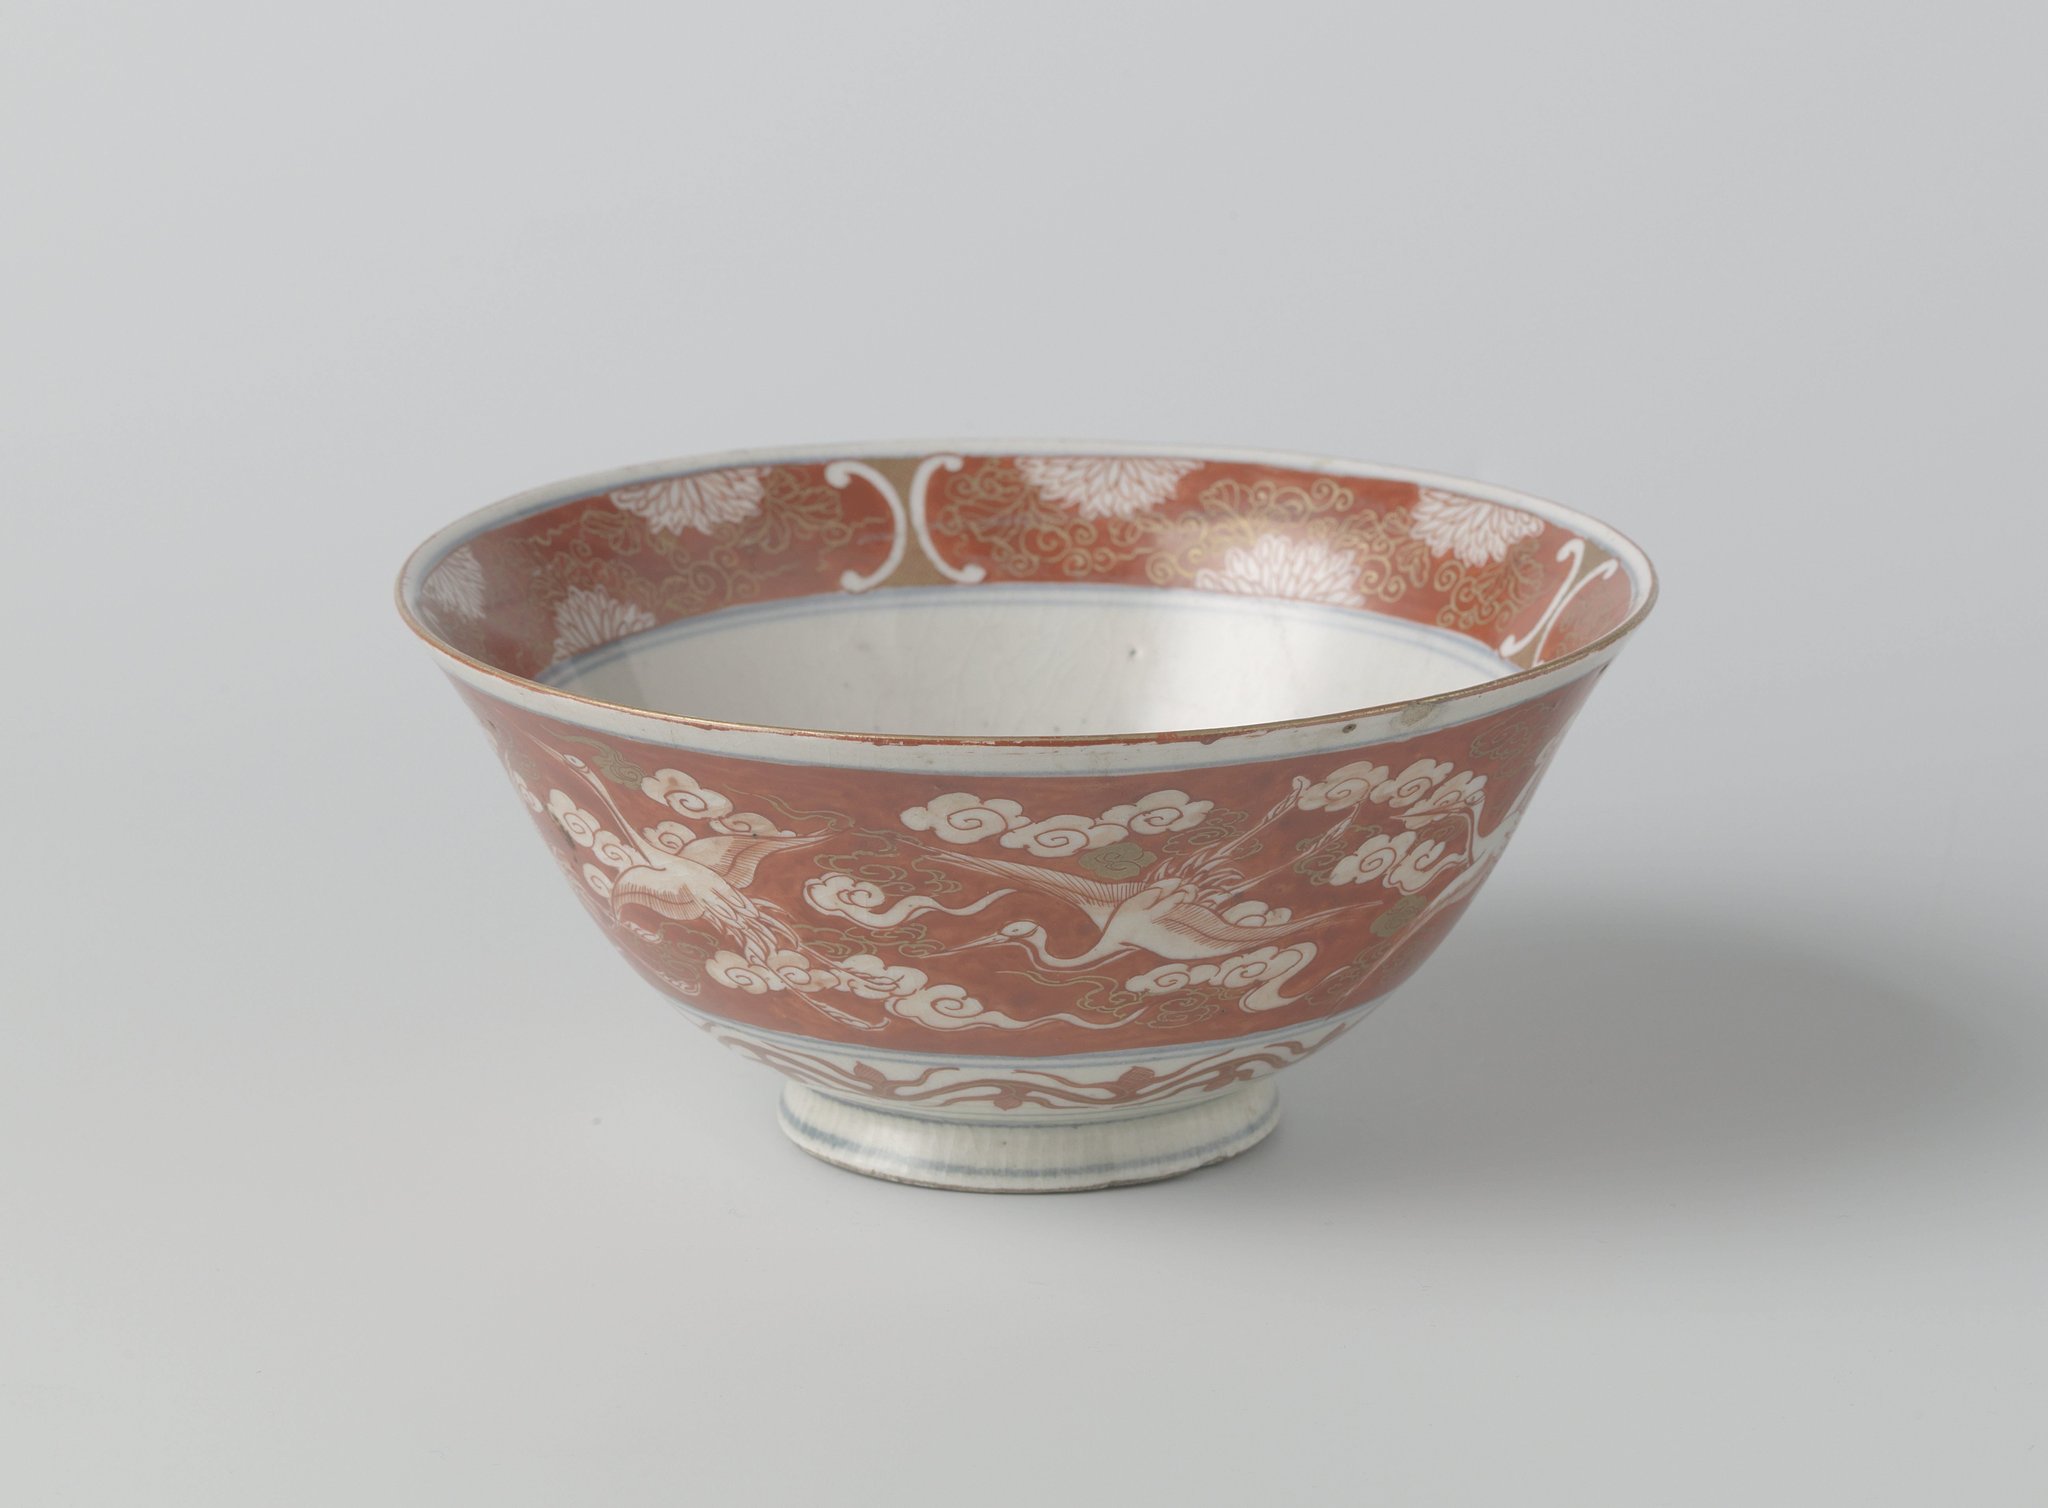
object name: bowl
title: Bowl with flying cranes, a pomegranate spray and floral scrolls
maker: Anonymous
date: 1700-1799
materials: cobalt, glaze, gold, paint, porcelain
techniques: firing, gilding, turning, vitrification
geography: japan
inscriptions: mark: ‘九谷’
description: Kom, met decor van vliegende kraanvogels en wolken in ijzerrode grond met goud.